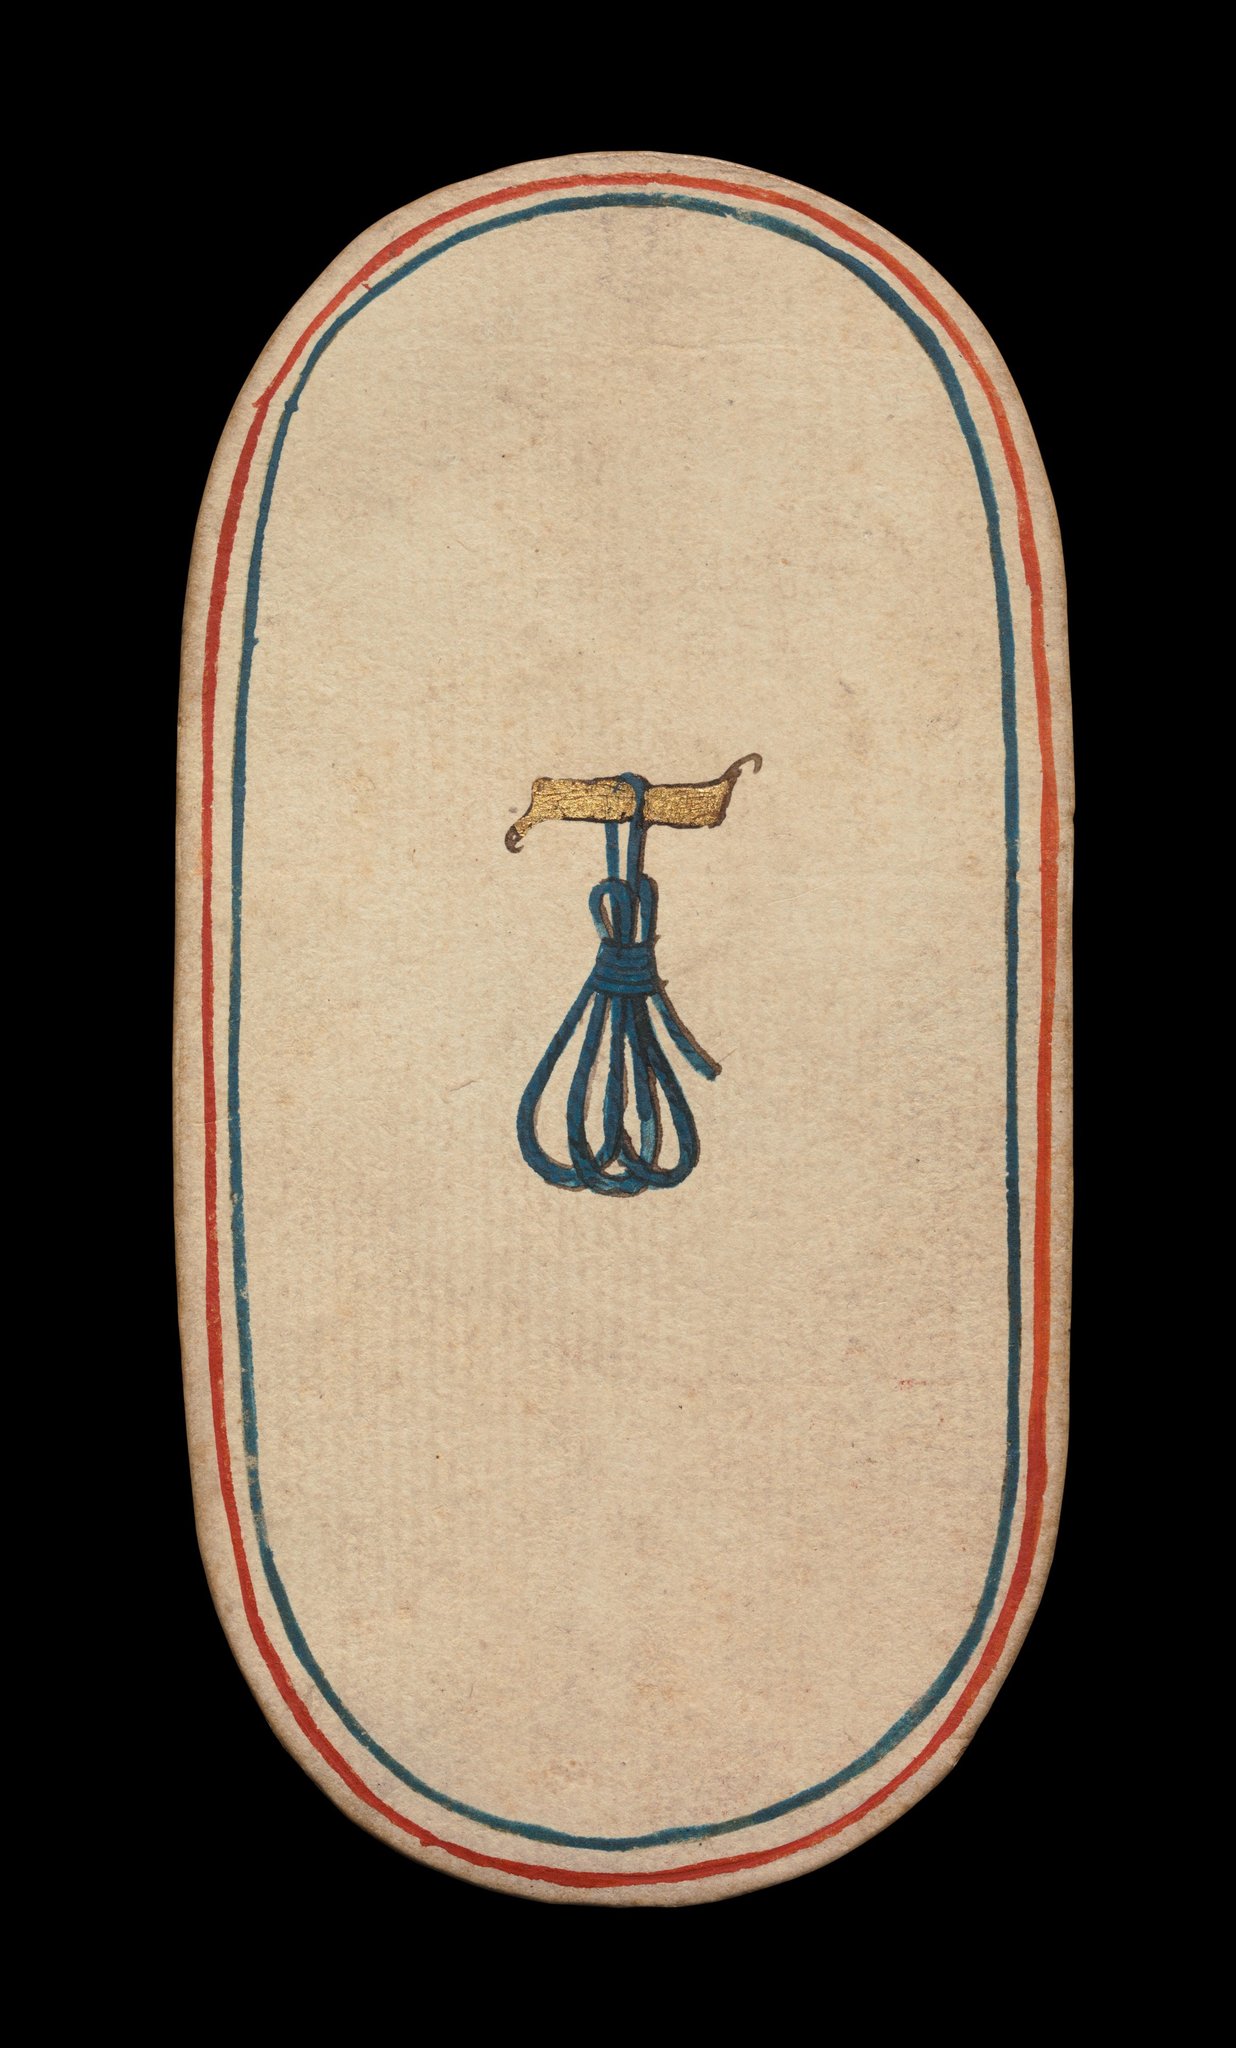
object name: playing card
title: 1 of Tethers, from The Cloisters Playing Cards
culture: south netherlandish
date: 1475-1480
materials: glaze, gold, ink, paint, paper, silver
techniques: pen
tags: playing cards,games